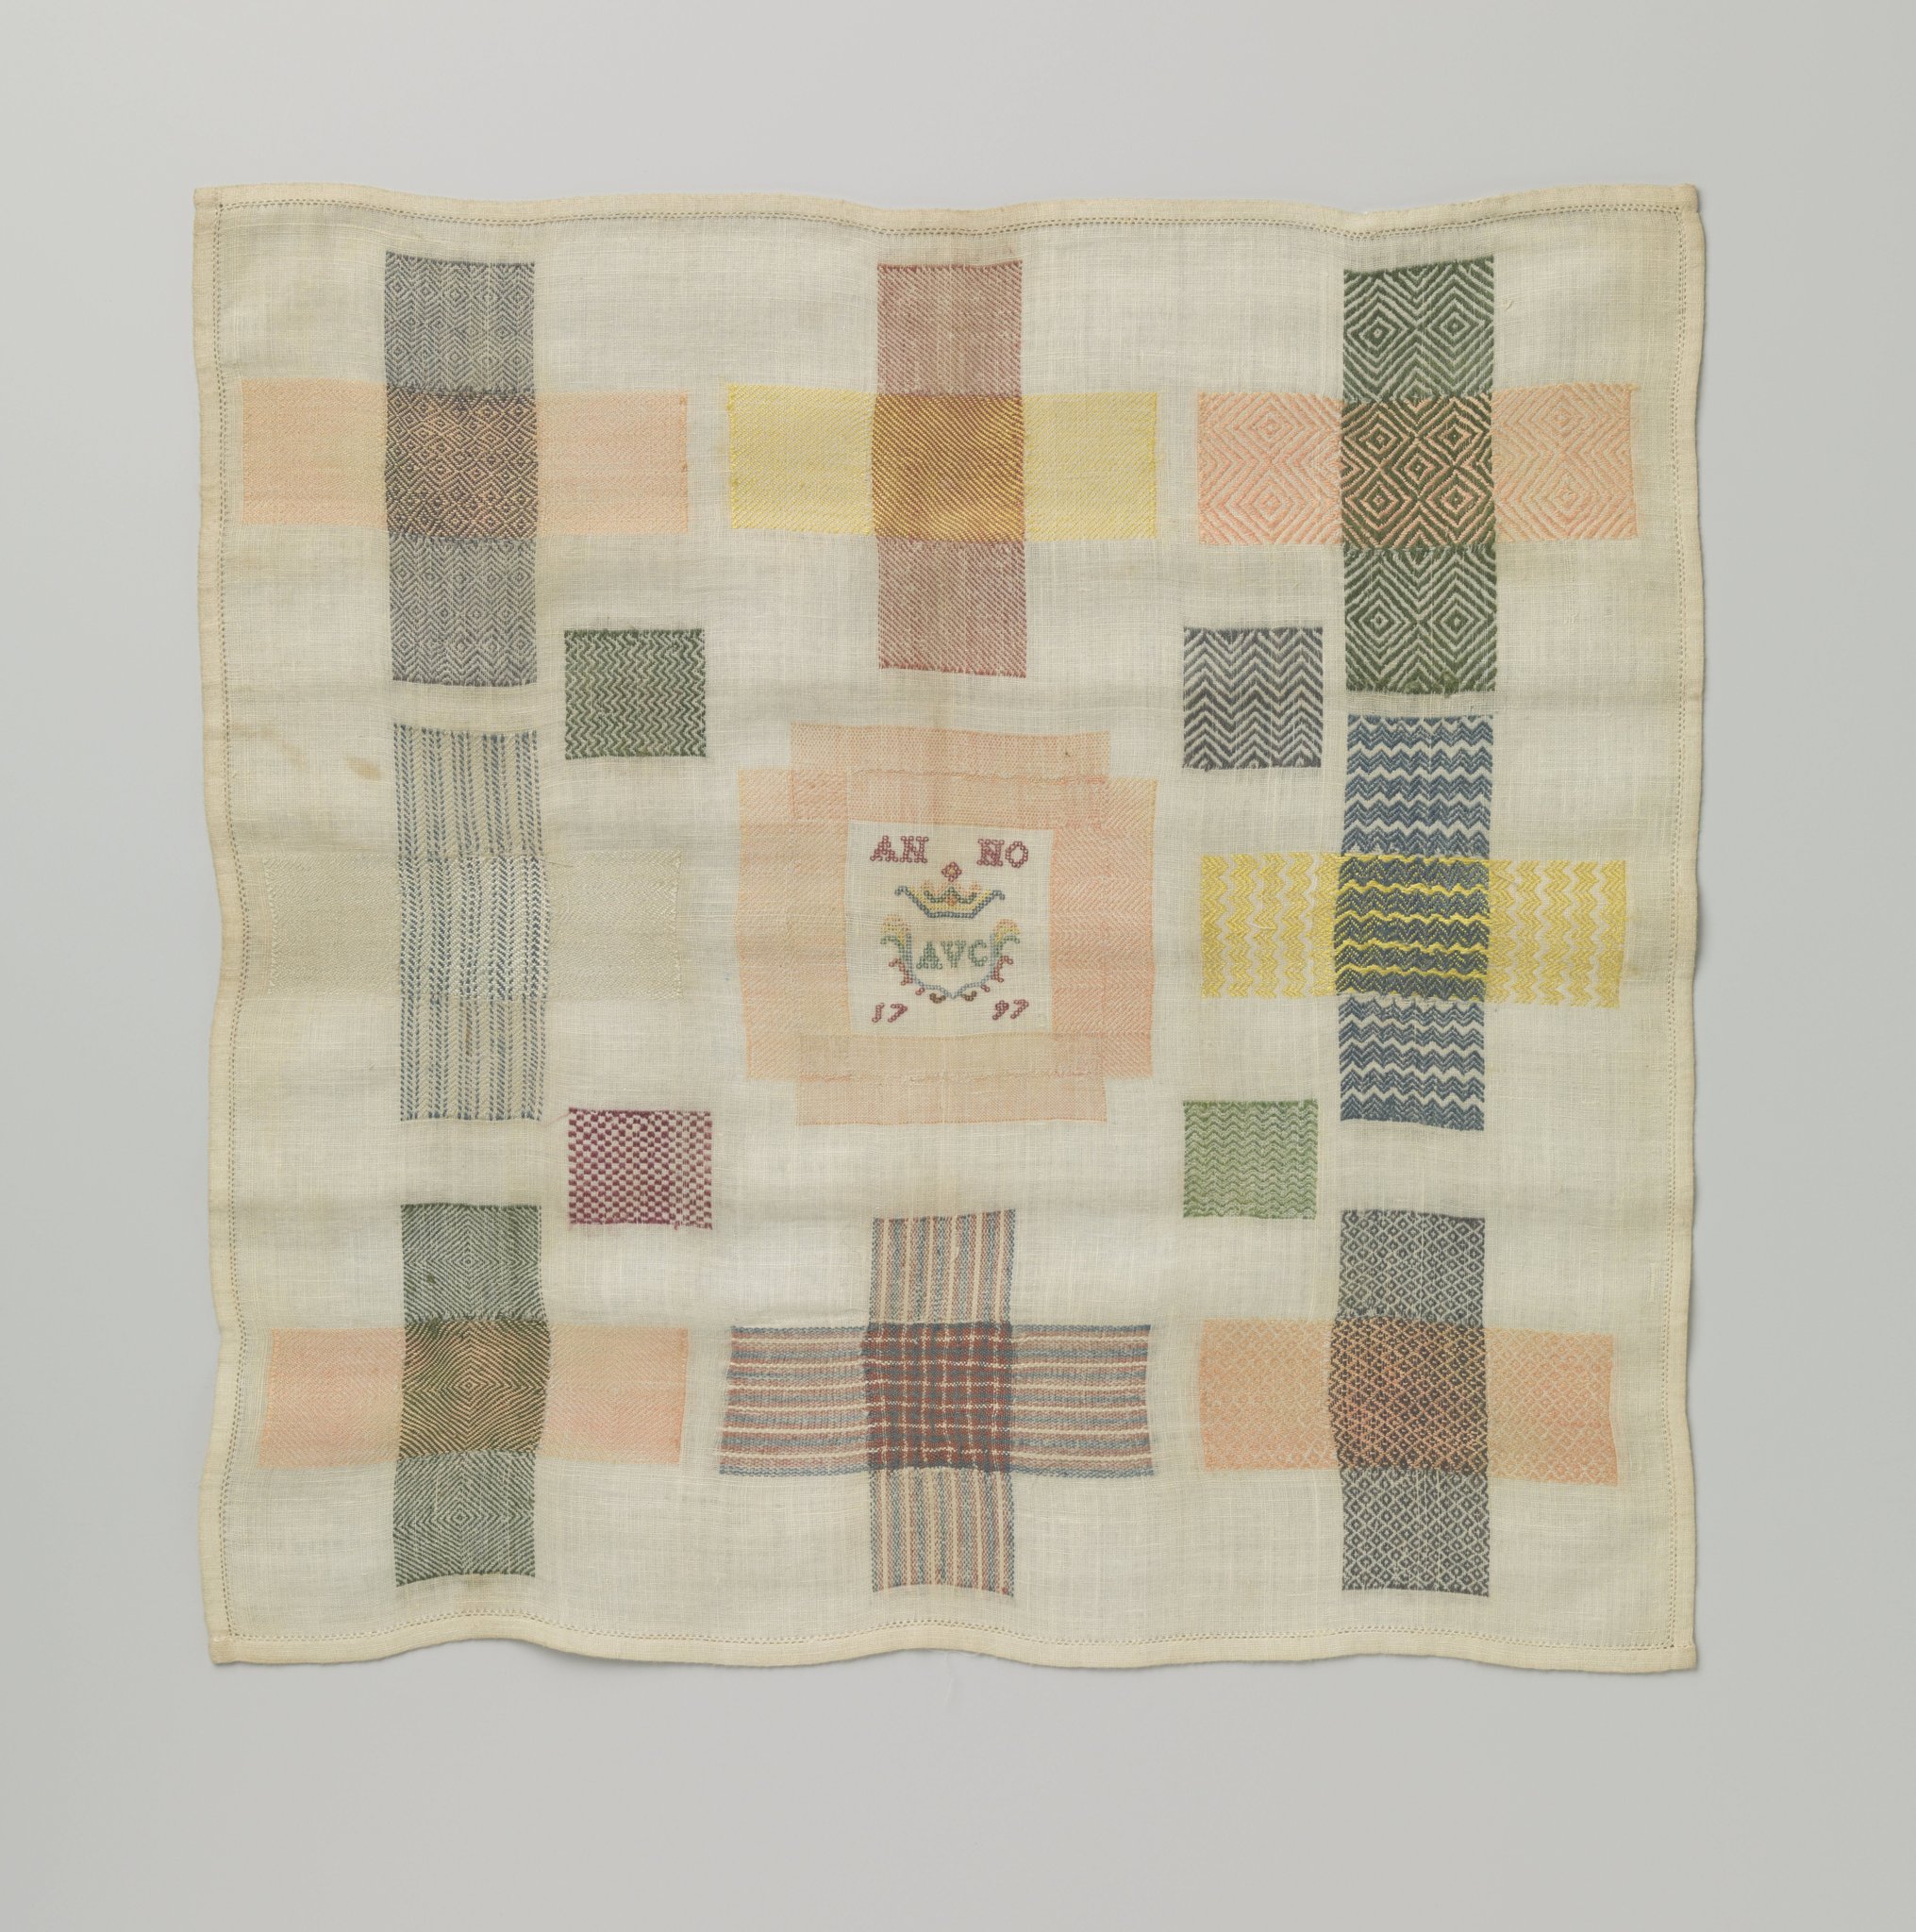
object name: stoplap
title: Stoplap van veelkleurige zijde op katoenen mousseline.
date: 1797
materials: cotton, silk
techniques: embroidered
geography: amsterdam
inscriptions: date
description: Stoplap met veelkleurig borduurwerk. Het borduurwerk bestaat uit een wapenschild met een kroon, de initialen AVC en ANNO 1797, waar omheen vier doorstoppen.